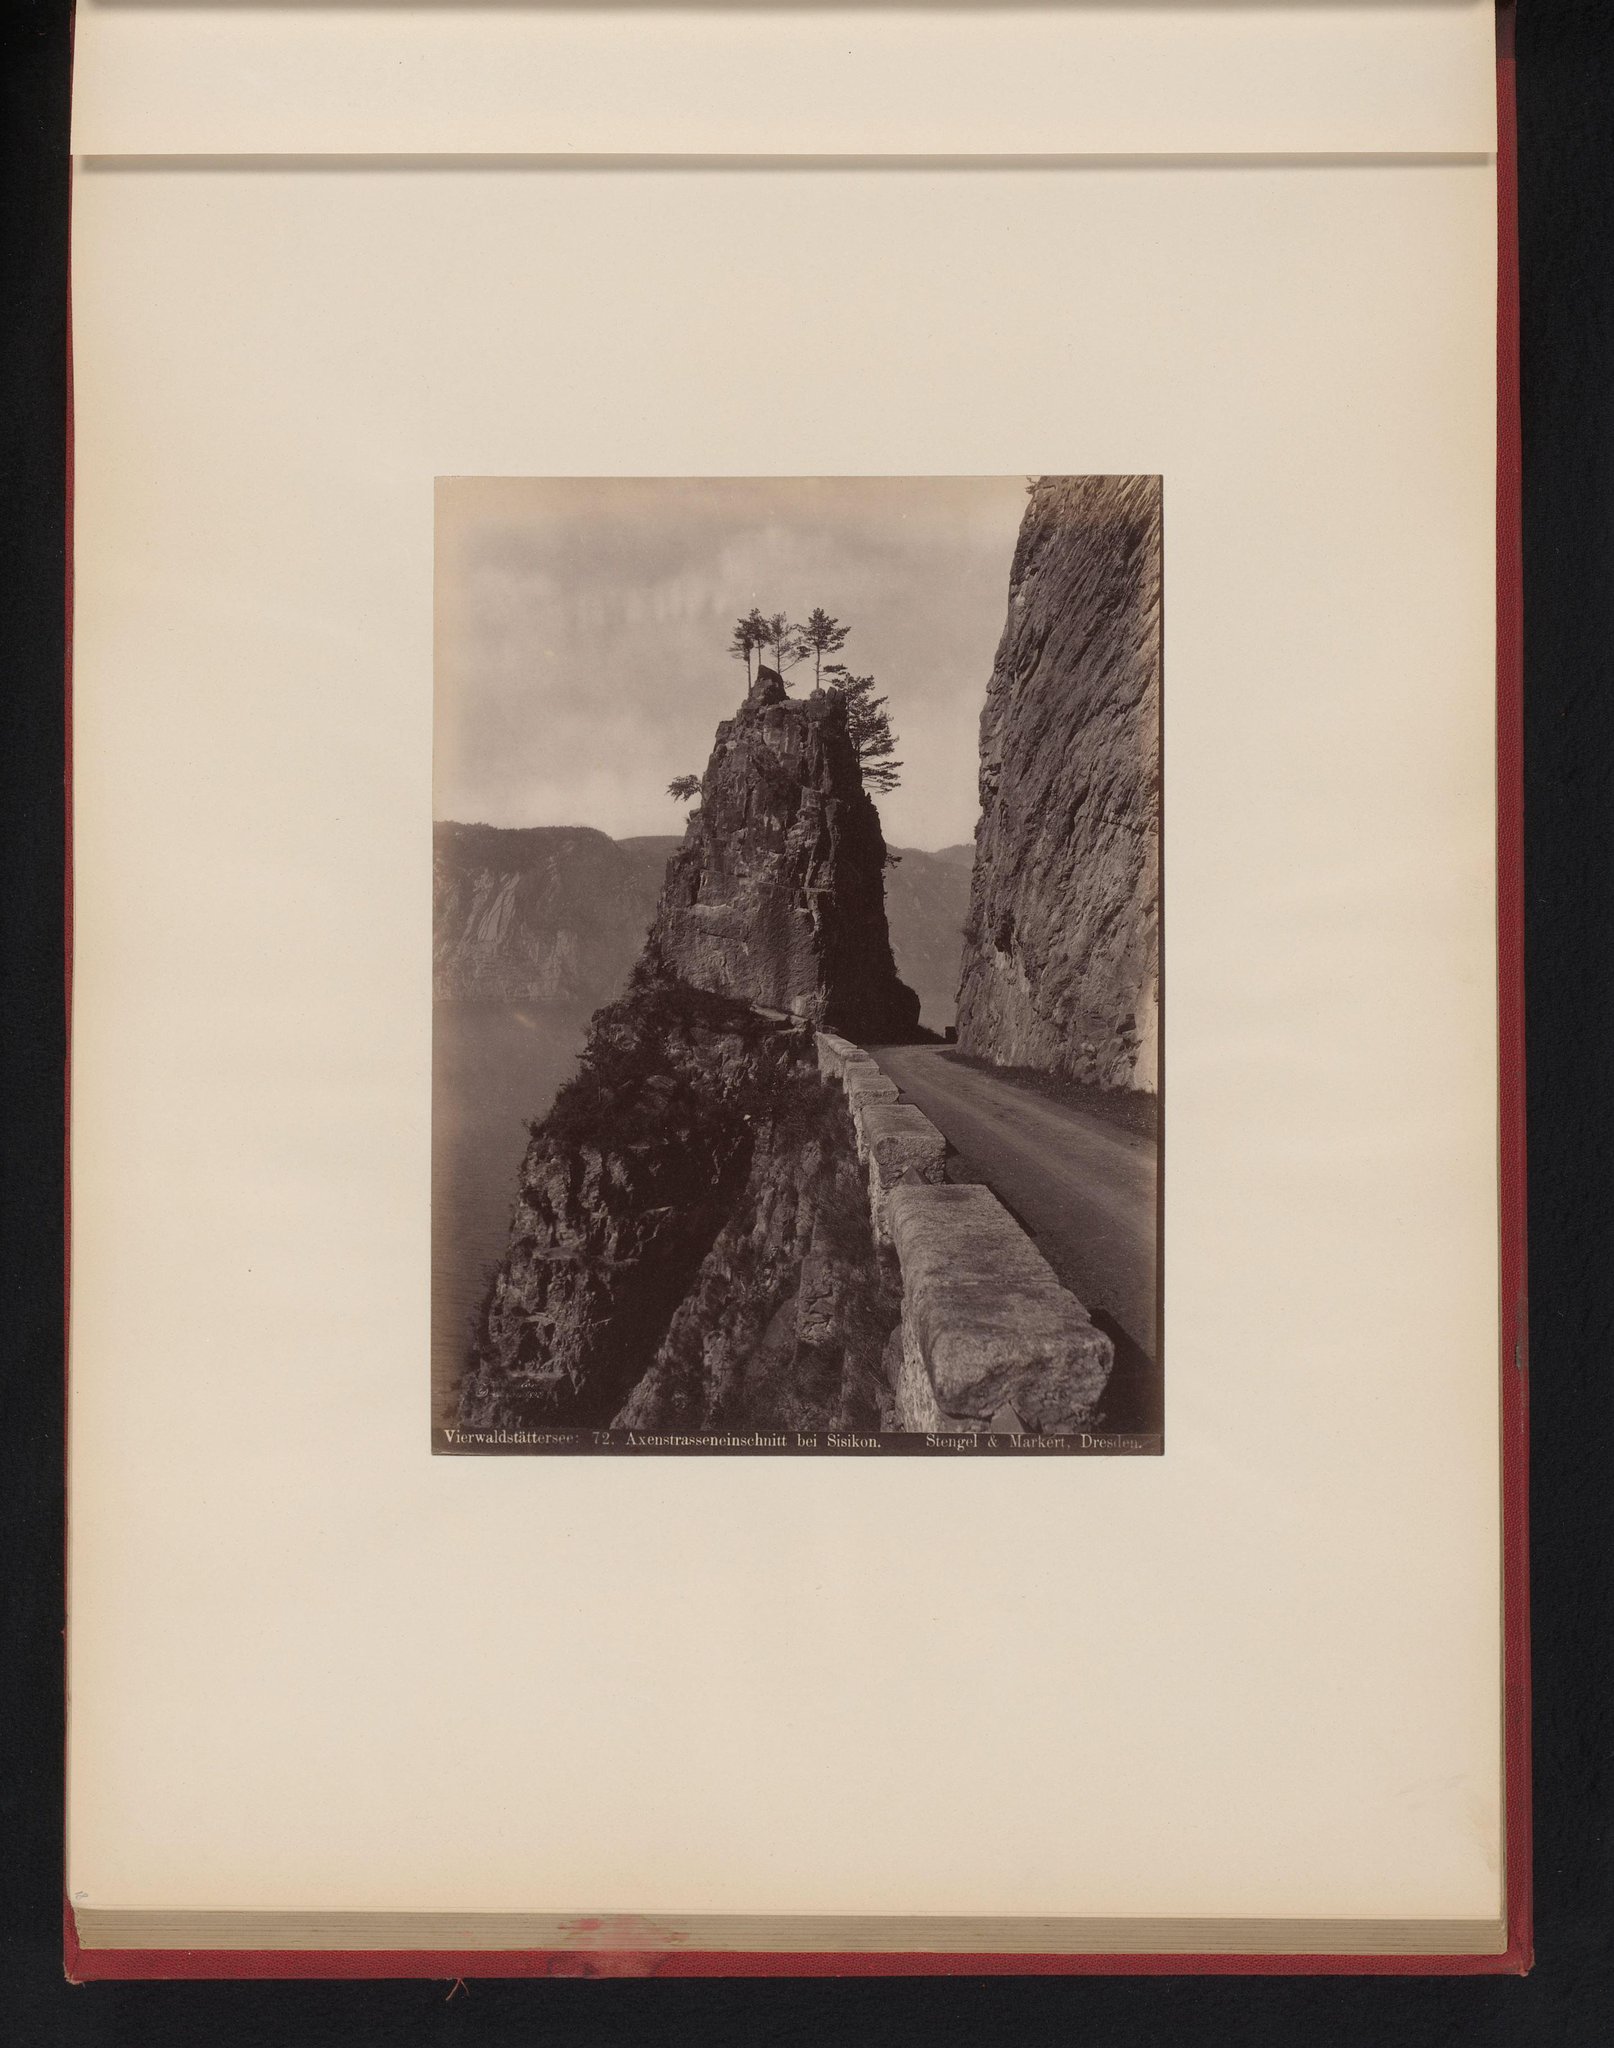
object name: photograph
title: Gezicht op een weg tussen de rotsen bij Sisikon te Zwitserland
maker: hugo engler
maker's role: fotograaf, lithograaf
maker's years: 1850-1931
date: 1892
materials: photographic support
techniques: albumen print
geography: sisikon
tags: landscapes in the temperate zone, public road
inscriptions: inscription: ‘Vierwaldstättersee: 72. Axensteinstrasseneinschnit bei Sisikon. Verlag von Stengel & Markert, Dresden’